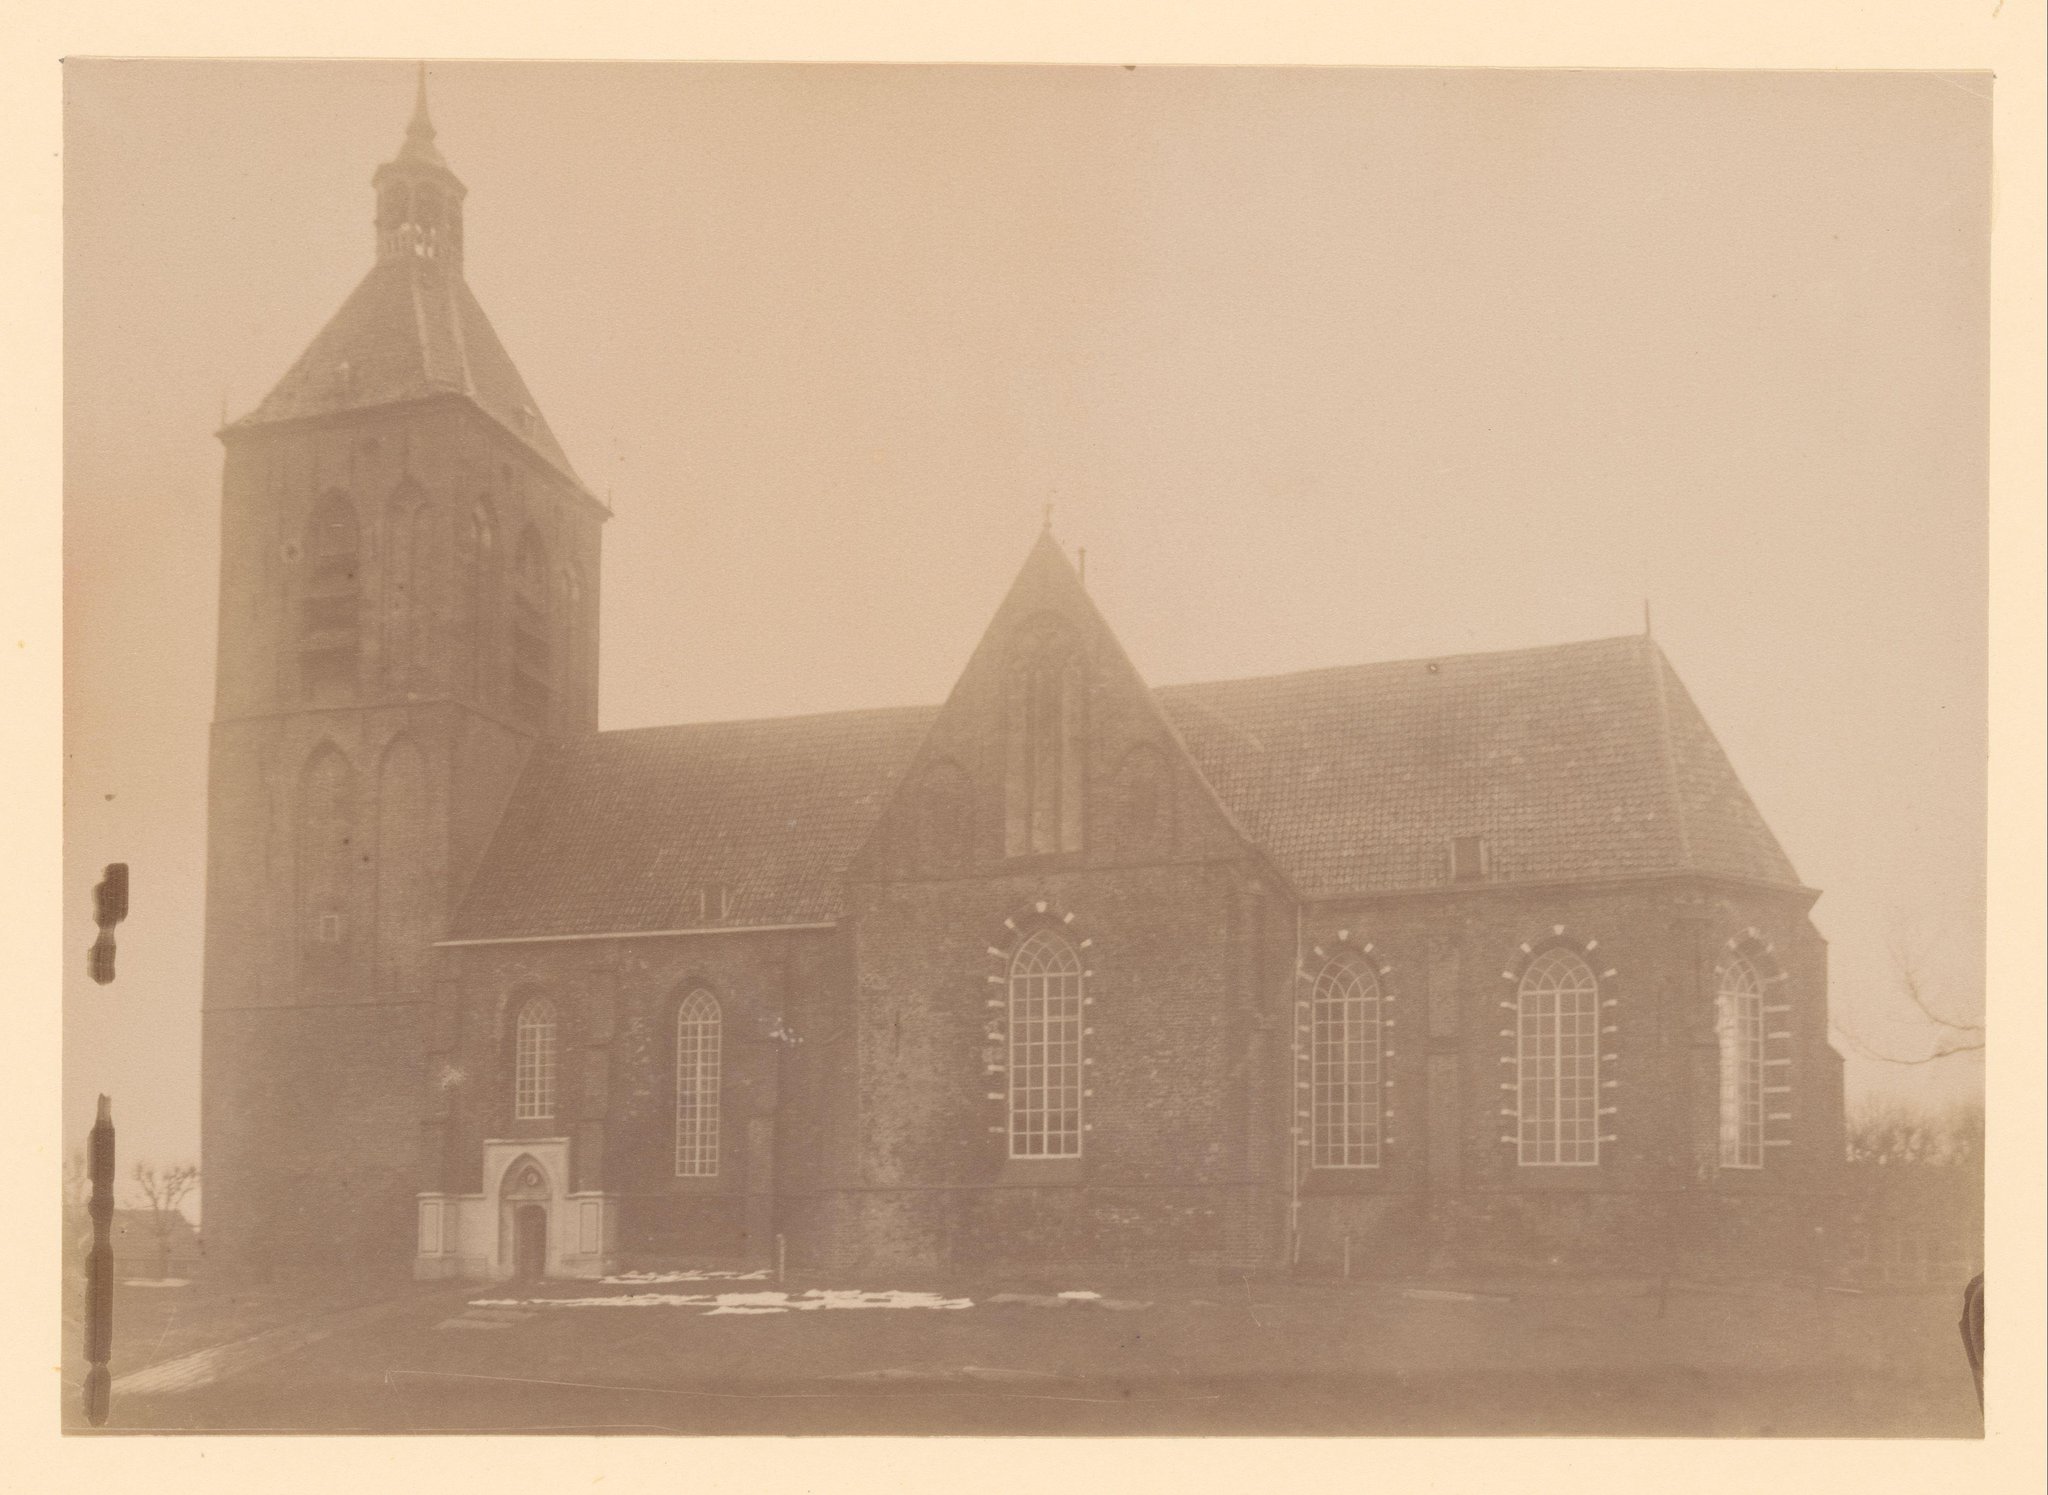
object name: photograph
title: Gezicht op de Sint-Hippolytuskerk te Middelstum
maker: anoniem (monumentenzorg)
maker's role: fotograaf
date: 1890-1910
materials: cardboard, photographic support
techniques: albumen print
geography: middelstum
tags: church (exterior)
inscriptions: annotation: ‘Middelstum’, annotation: ‘N.H. kerk te Middelstum’